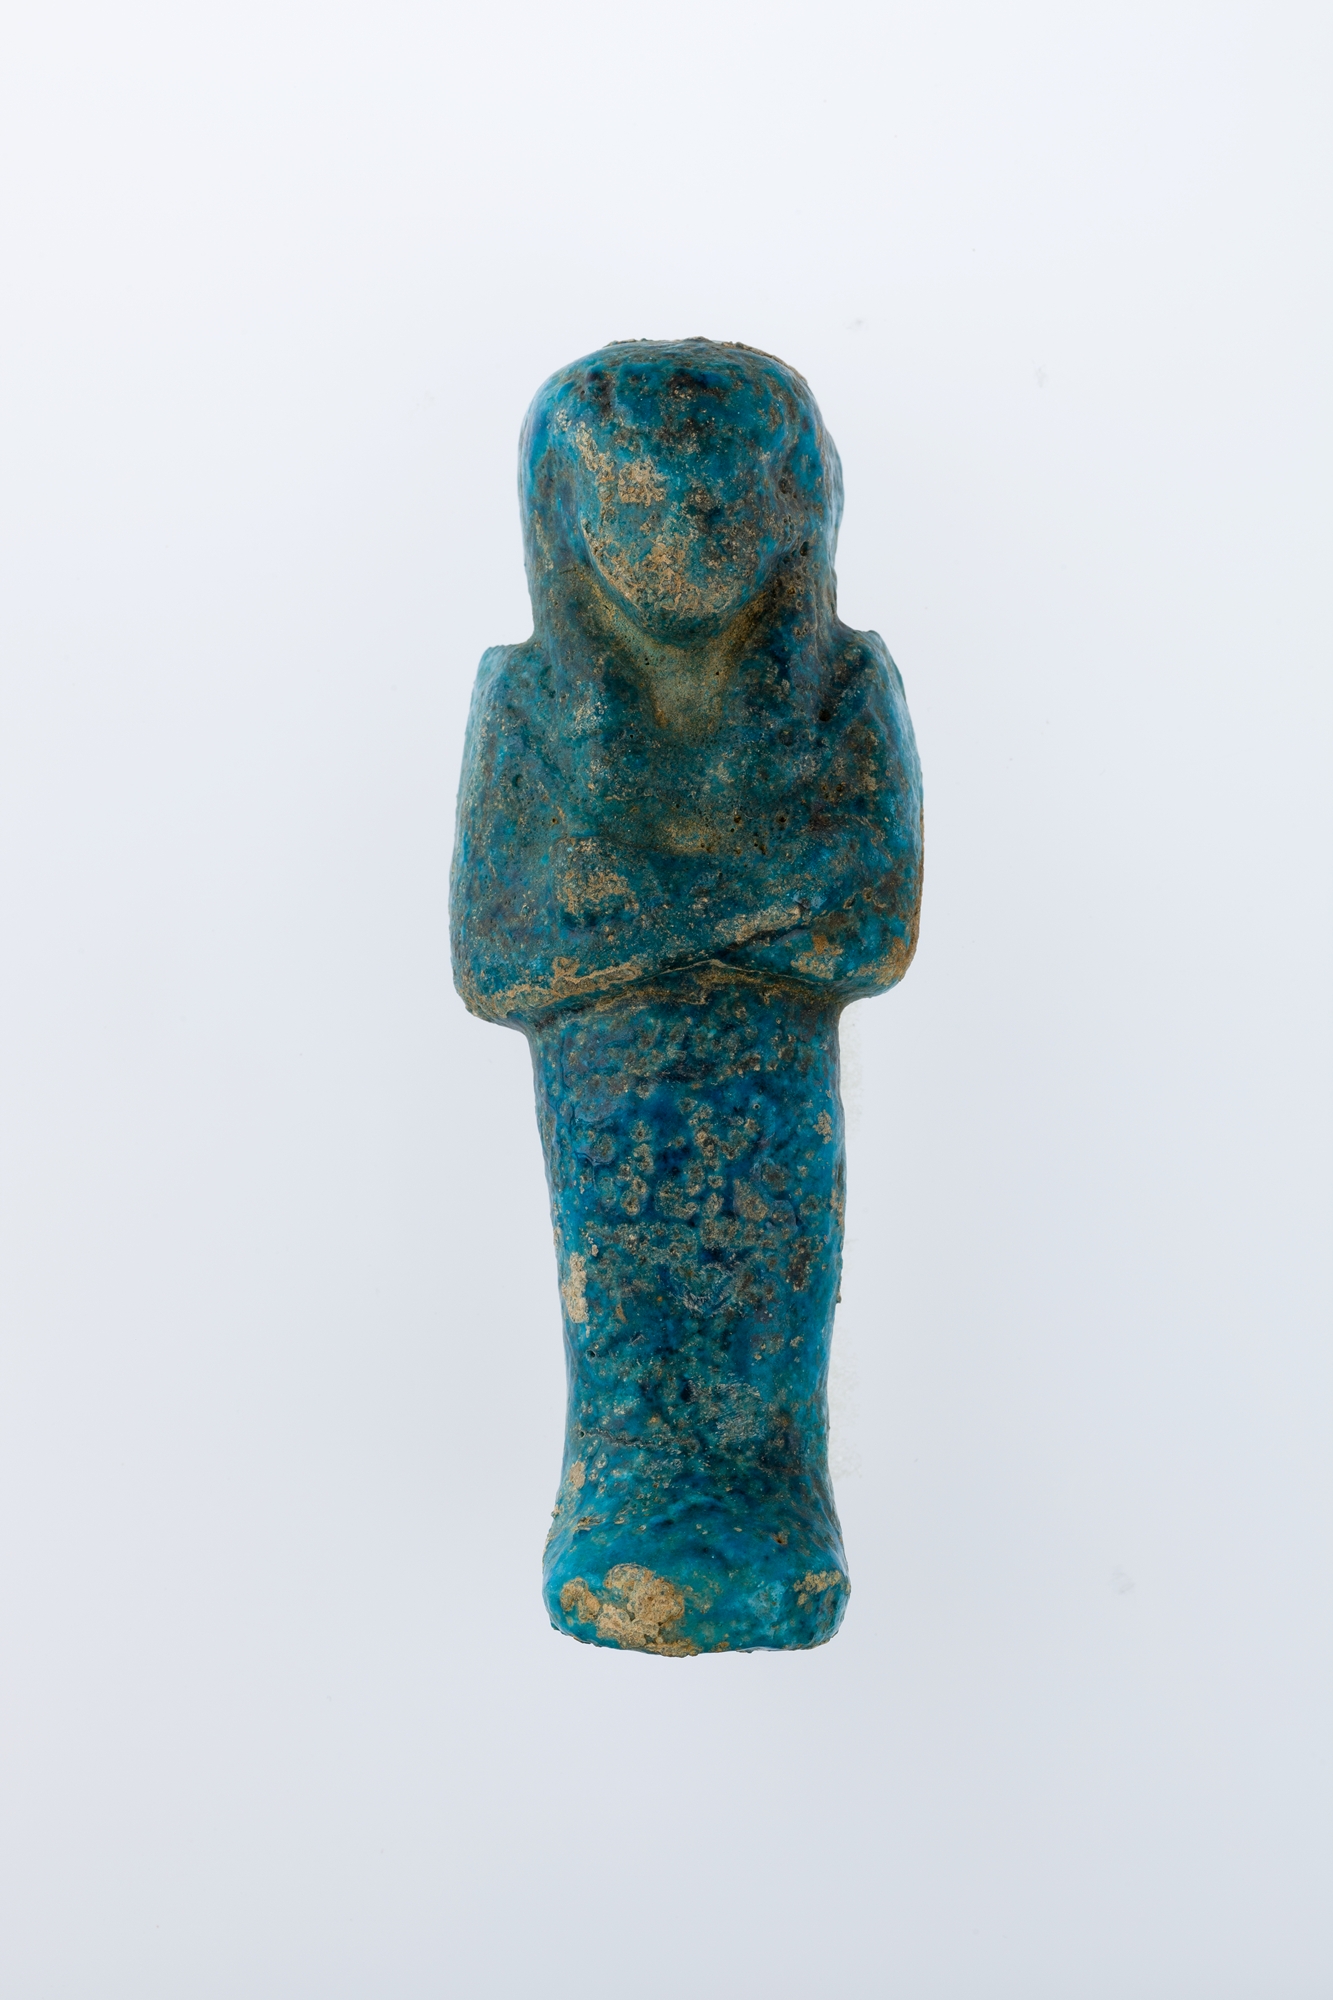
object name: shabti, henettawy c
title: Worker Shabti of Henettawy (C), Daughter of Isetemkheb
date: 990-970 BCE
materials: faience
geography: egypt